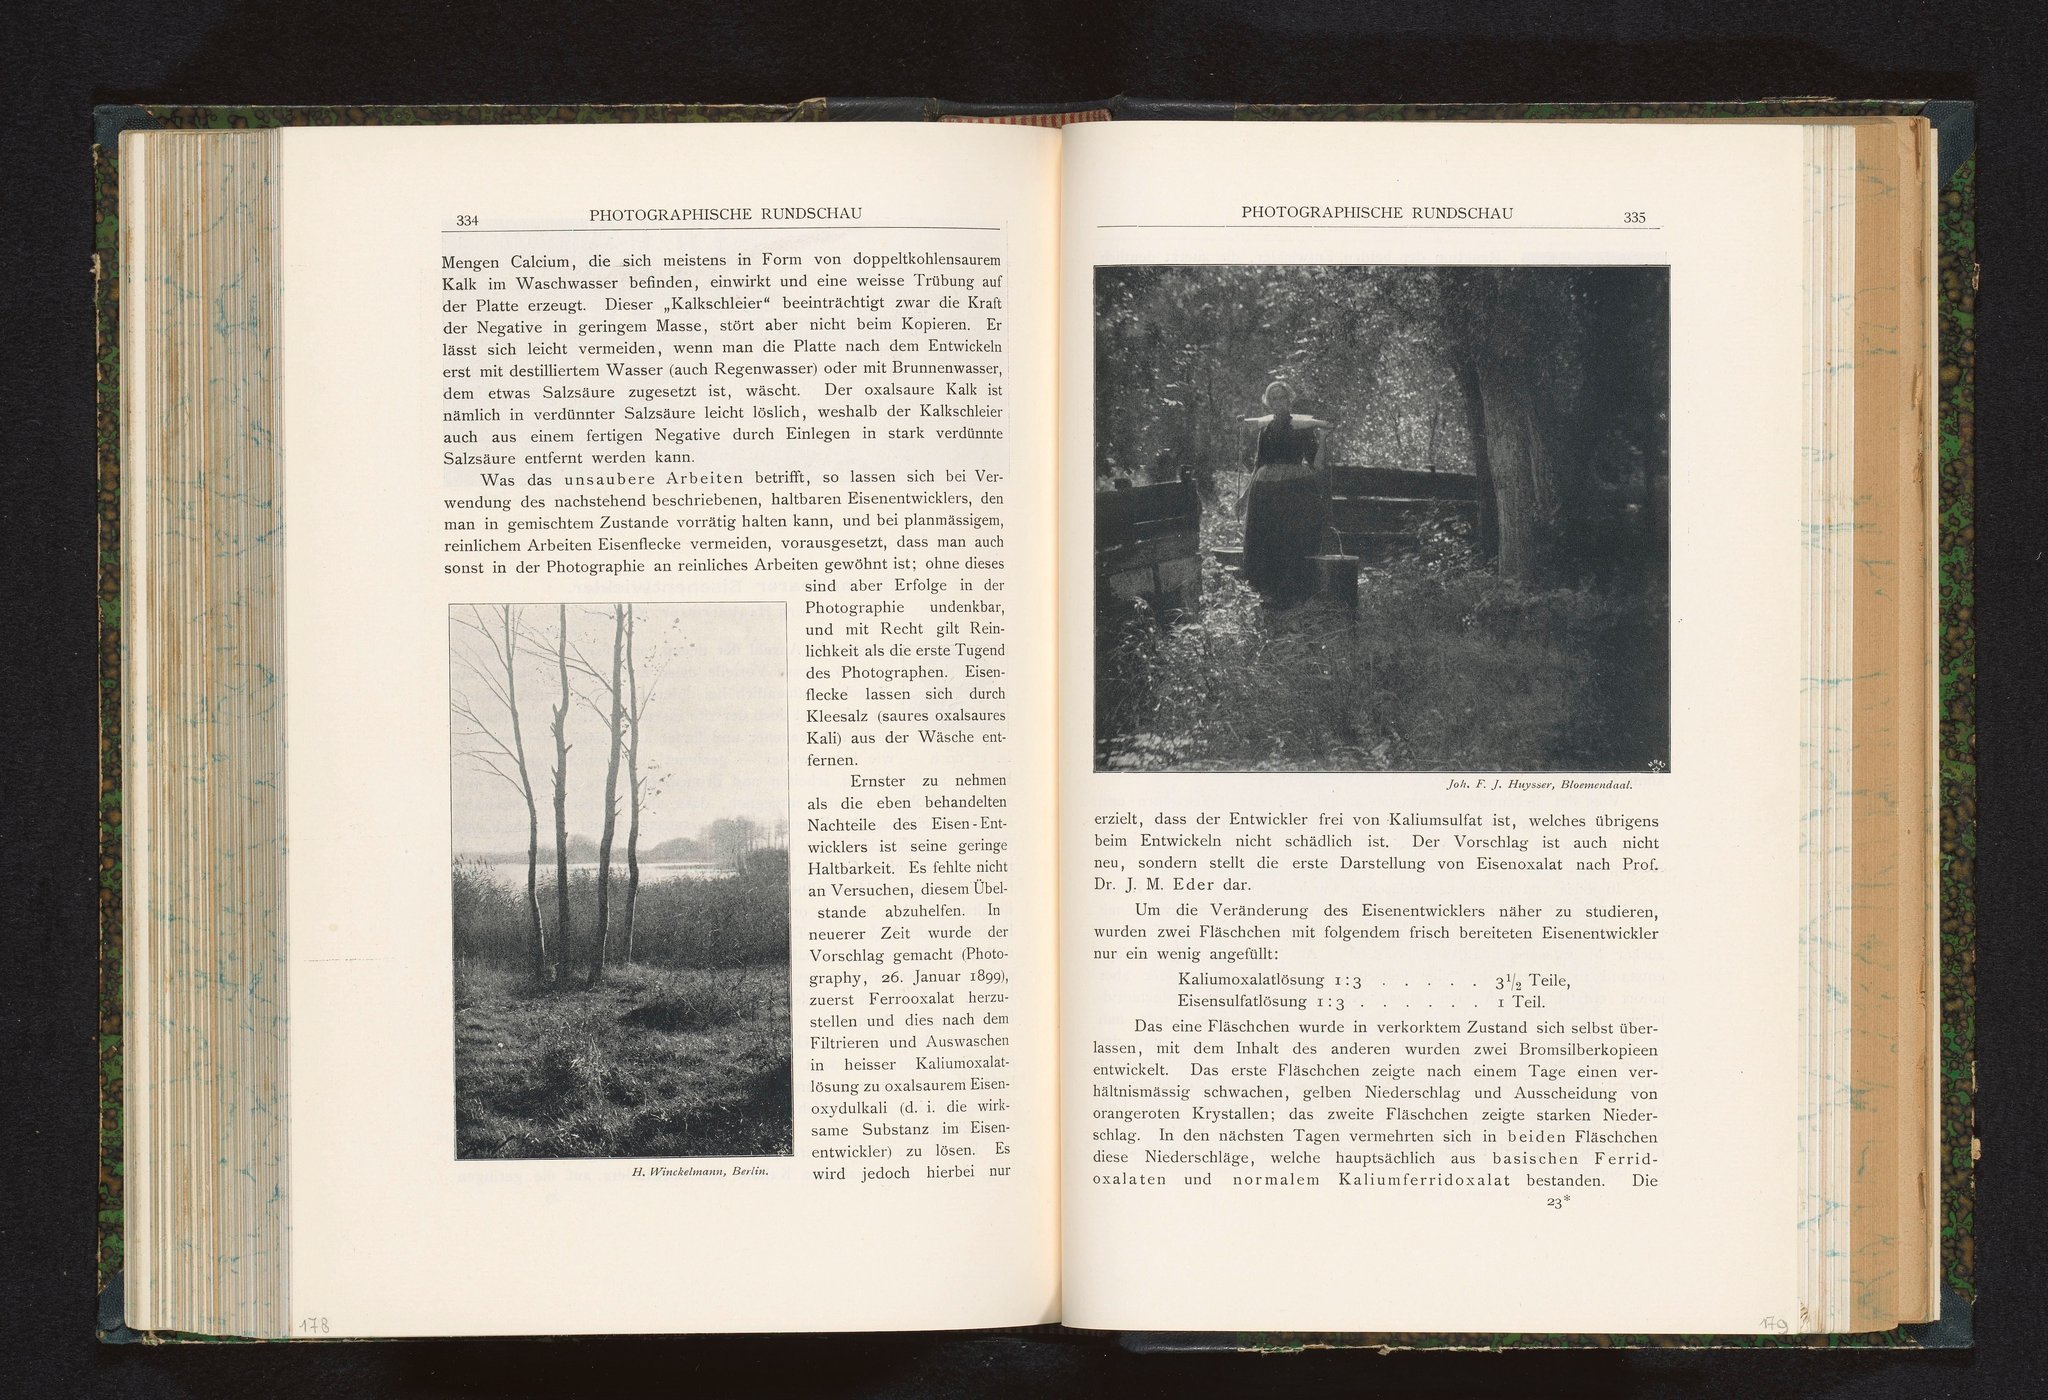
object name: photomechanical print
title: Vier stammen van bomen op een oever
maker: h. winckelmann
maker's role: fotograaf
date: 1894-1899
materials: paper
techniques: autotype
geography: berlin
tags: trees, river bank